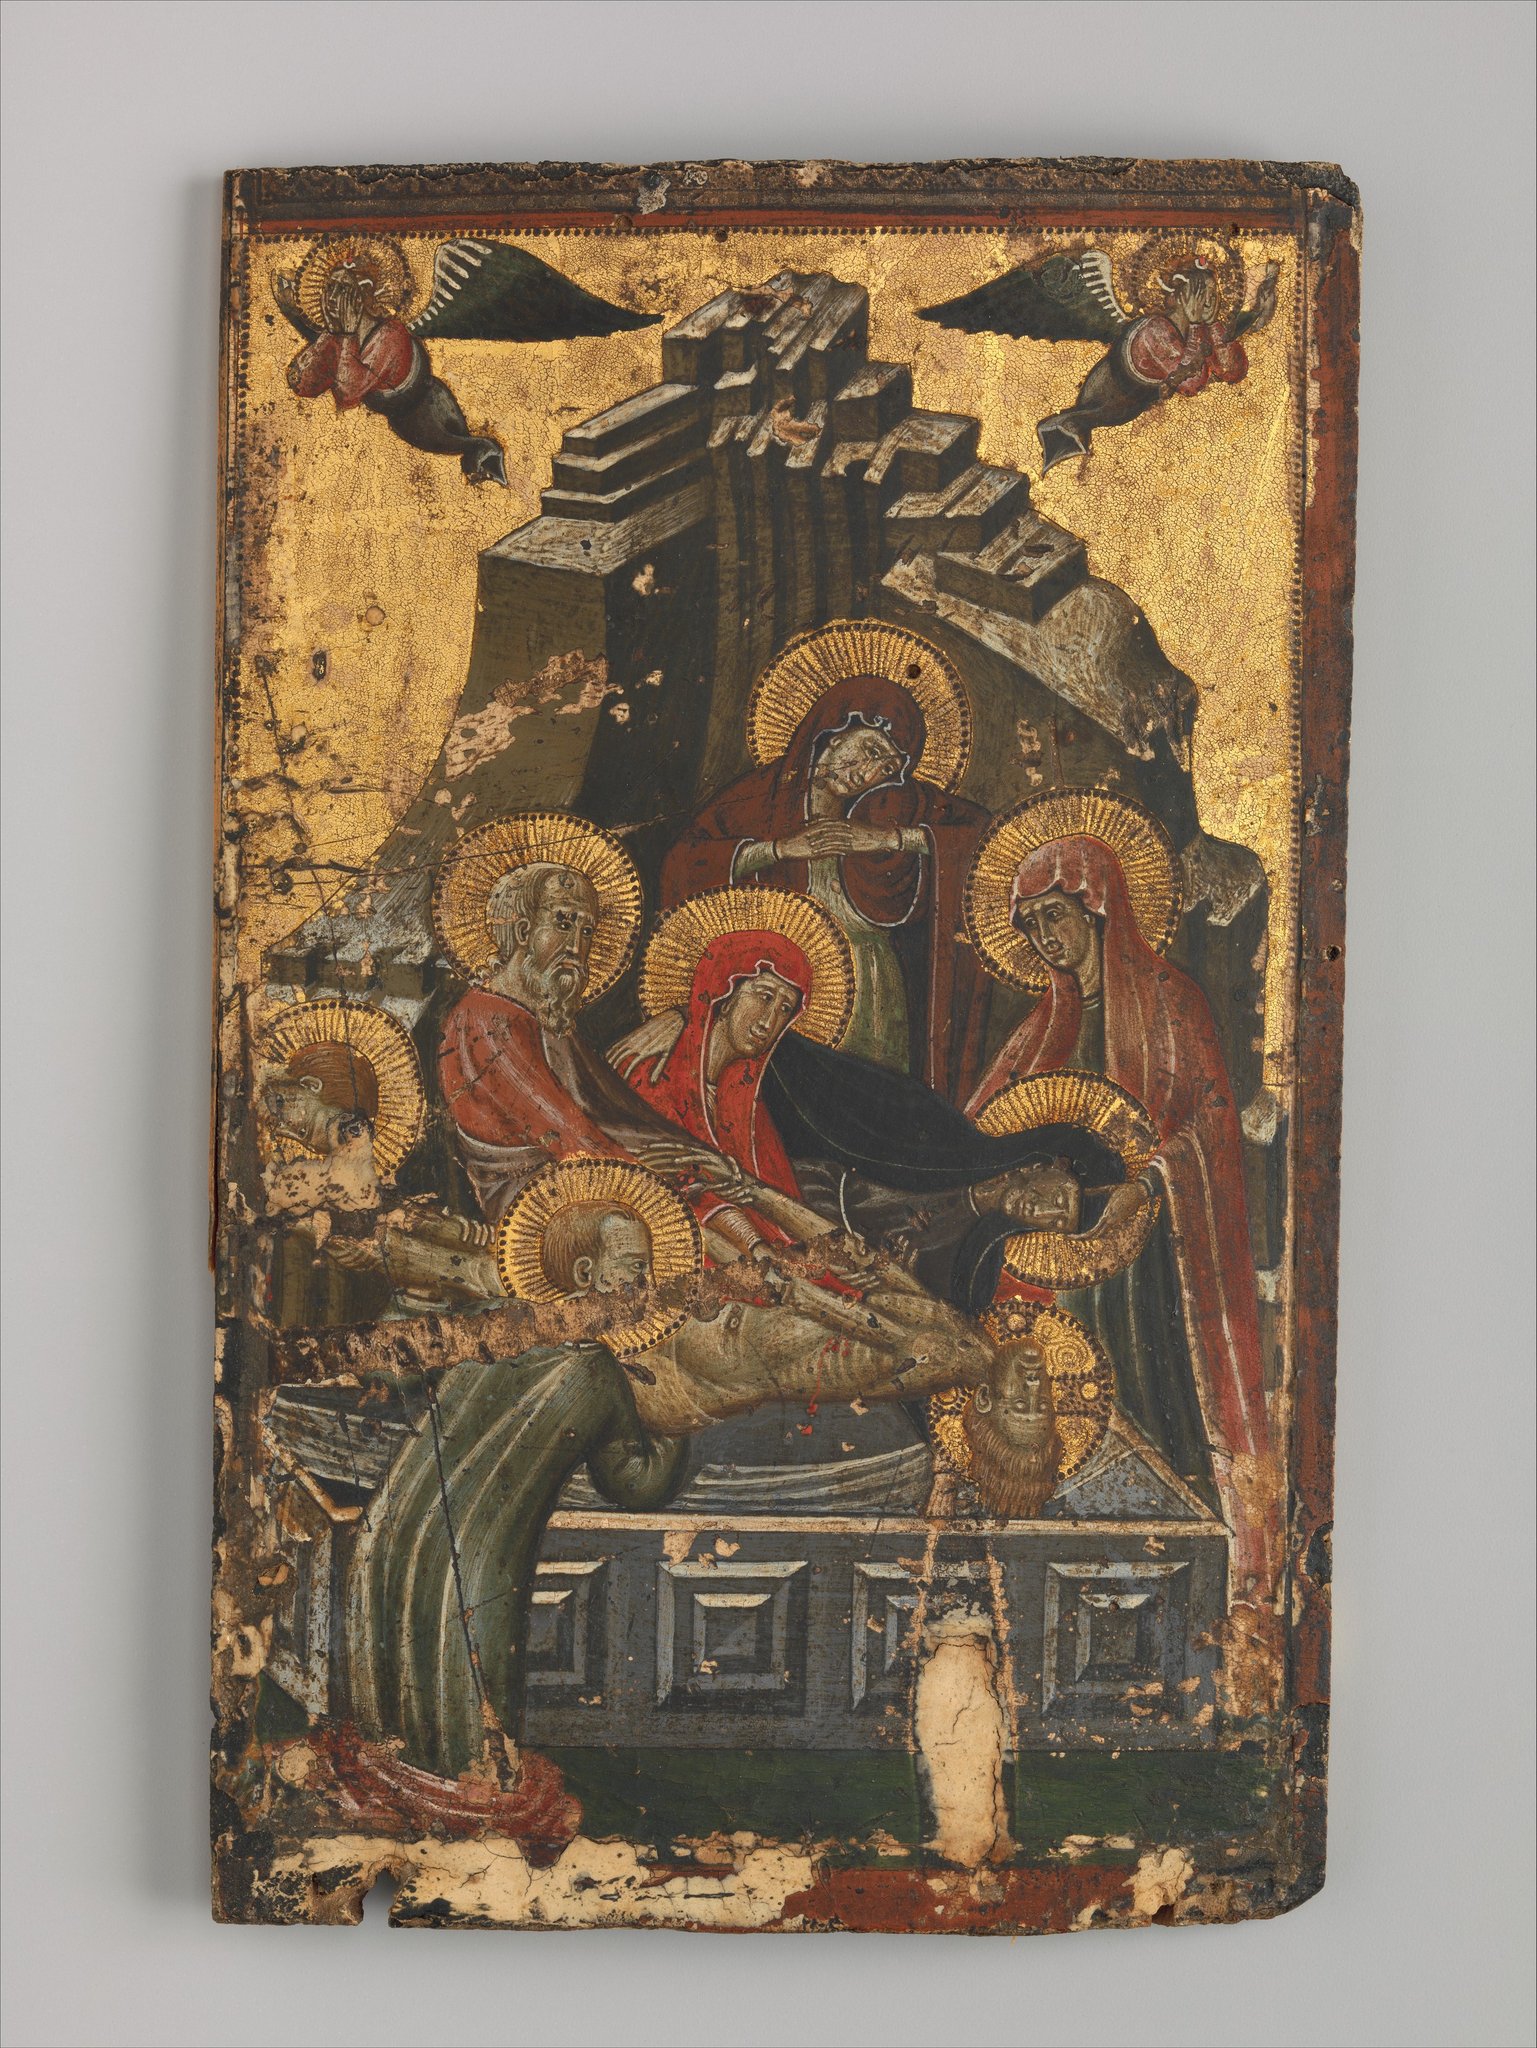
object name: painting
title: The Entombment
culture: italian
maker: master of forlì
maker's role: artist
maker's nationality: italian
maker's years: 1300-1350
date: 1301-1350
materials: gold leaf, paint, wood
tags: angels,christ,virgin mary,entombment